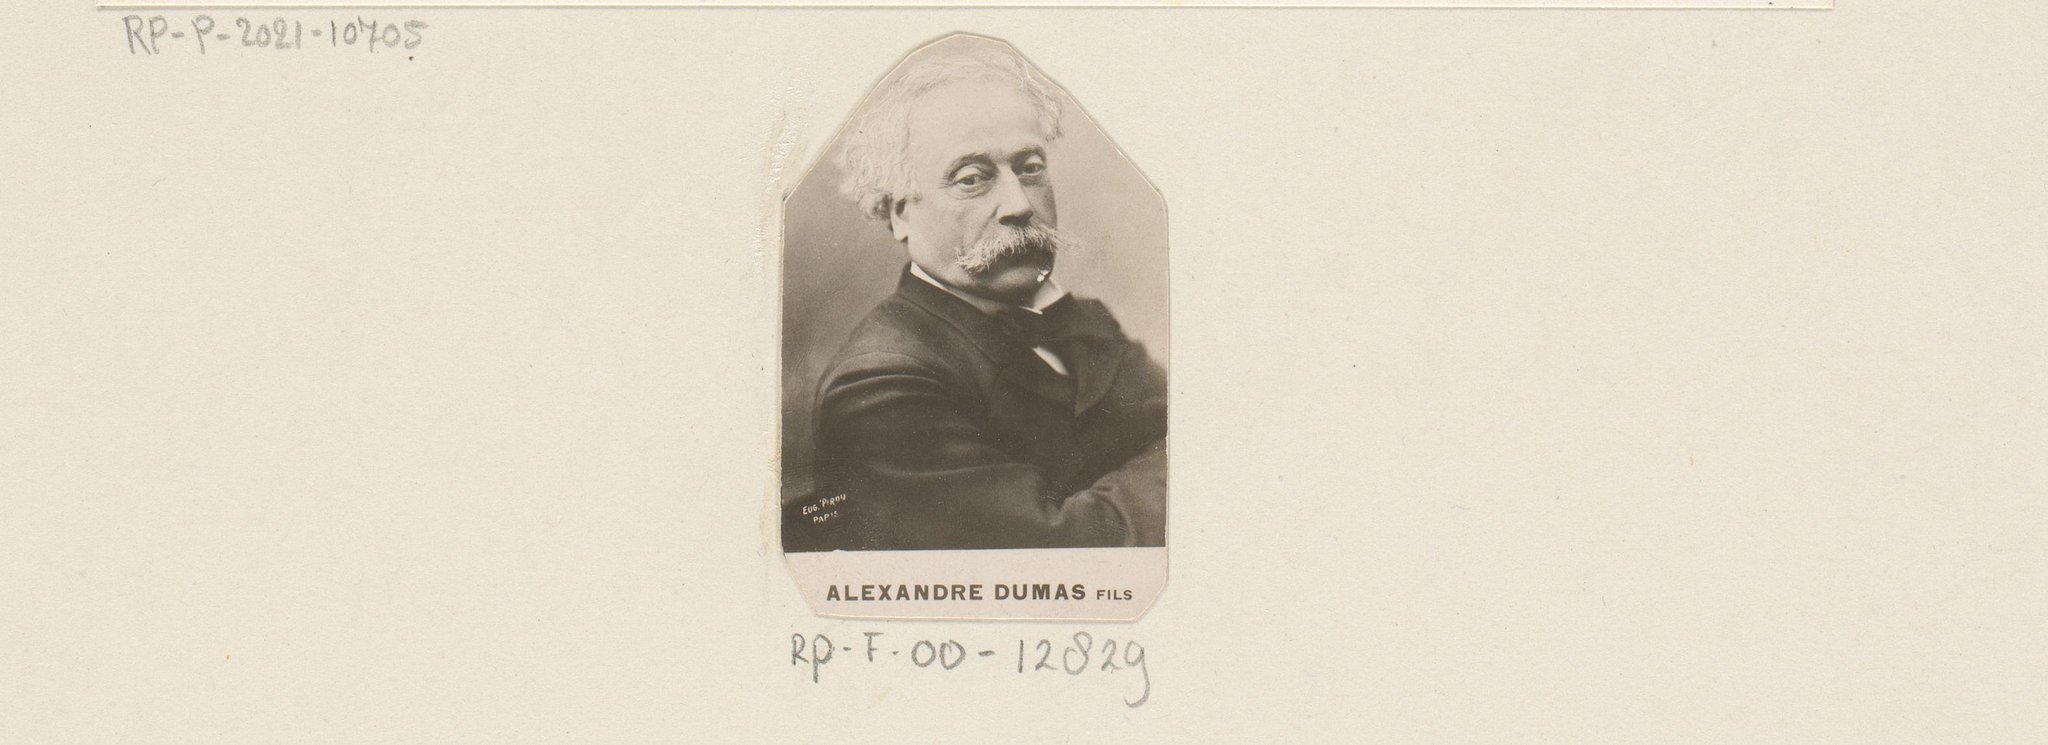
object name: photograph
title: Portret van Alexandre Dumas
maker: eugène pirou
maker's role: fotograaf, fotostudio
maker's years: 1841-1909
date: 1890-1895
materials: paper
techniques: gelatin silver print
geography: paris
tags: paris, portrait of a writer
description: Dergelijke foto's stonden bekend als 'zwartjes'. Men verkreeg ze bij aanschaf van bepaalde merken thee, cacao, sigaretten, beschuit, etc. om te verzamelen. Er waren speciaal voor de 'zwartjes' vervaardigde verzamelalbums in omloop.